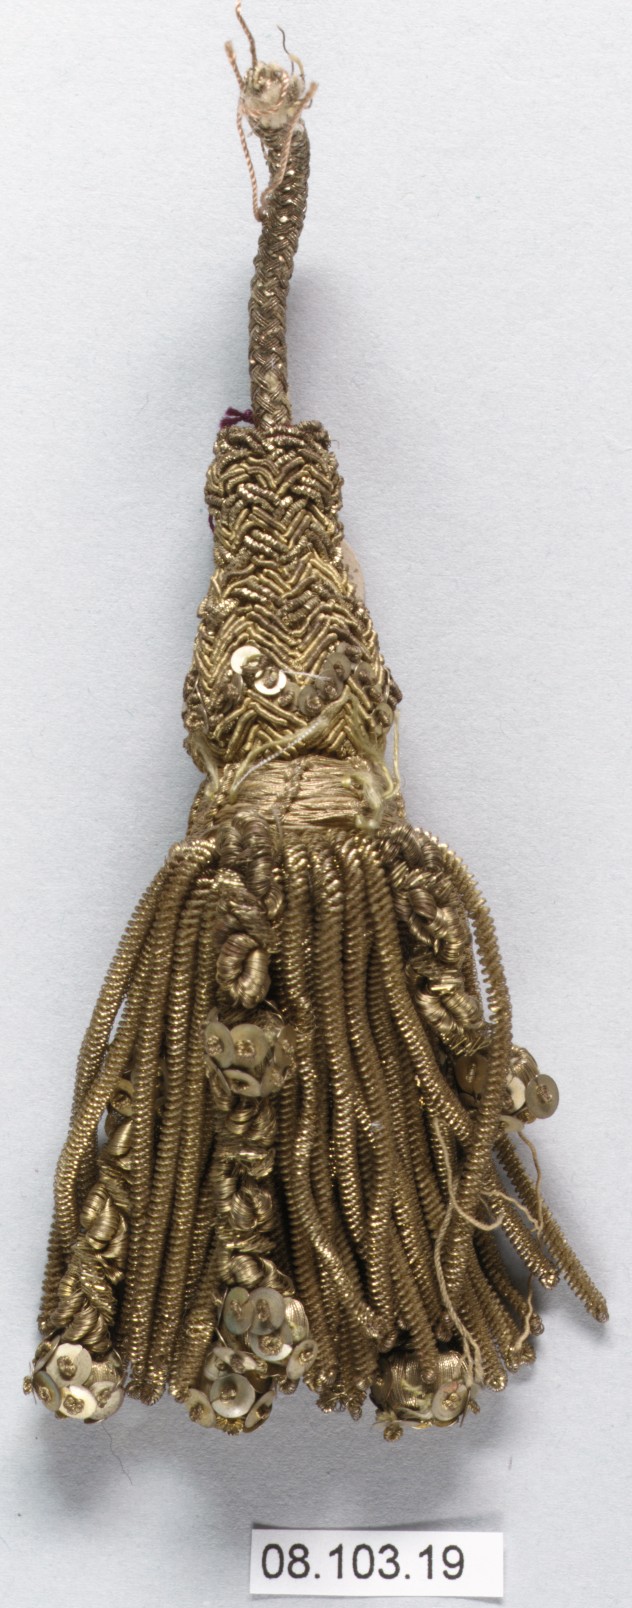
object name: tassel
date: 1801-1833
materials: metal thread